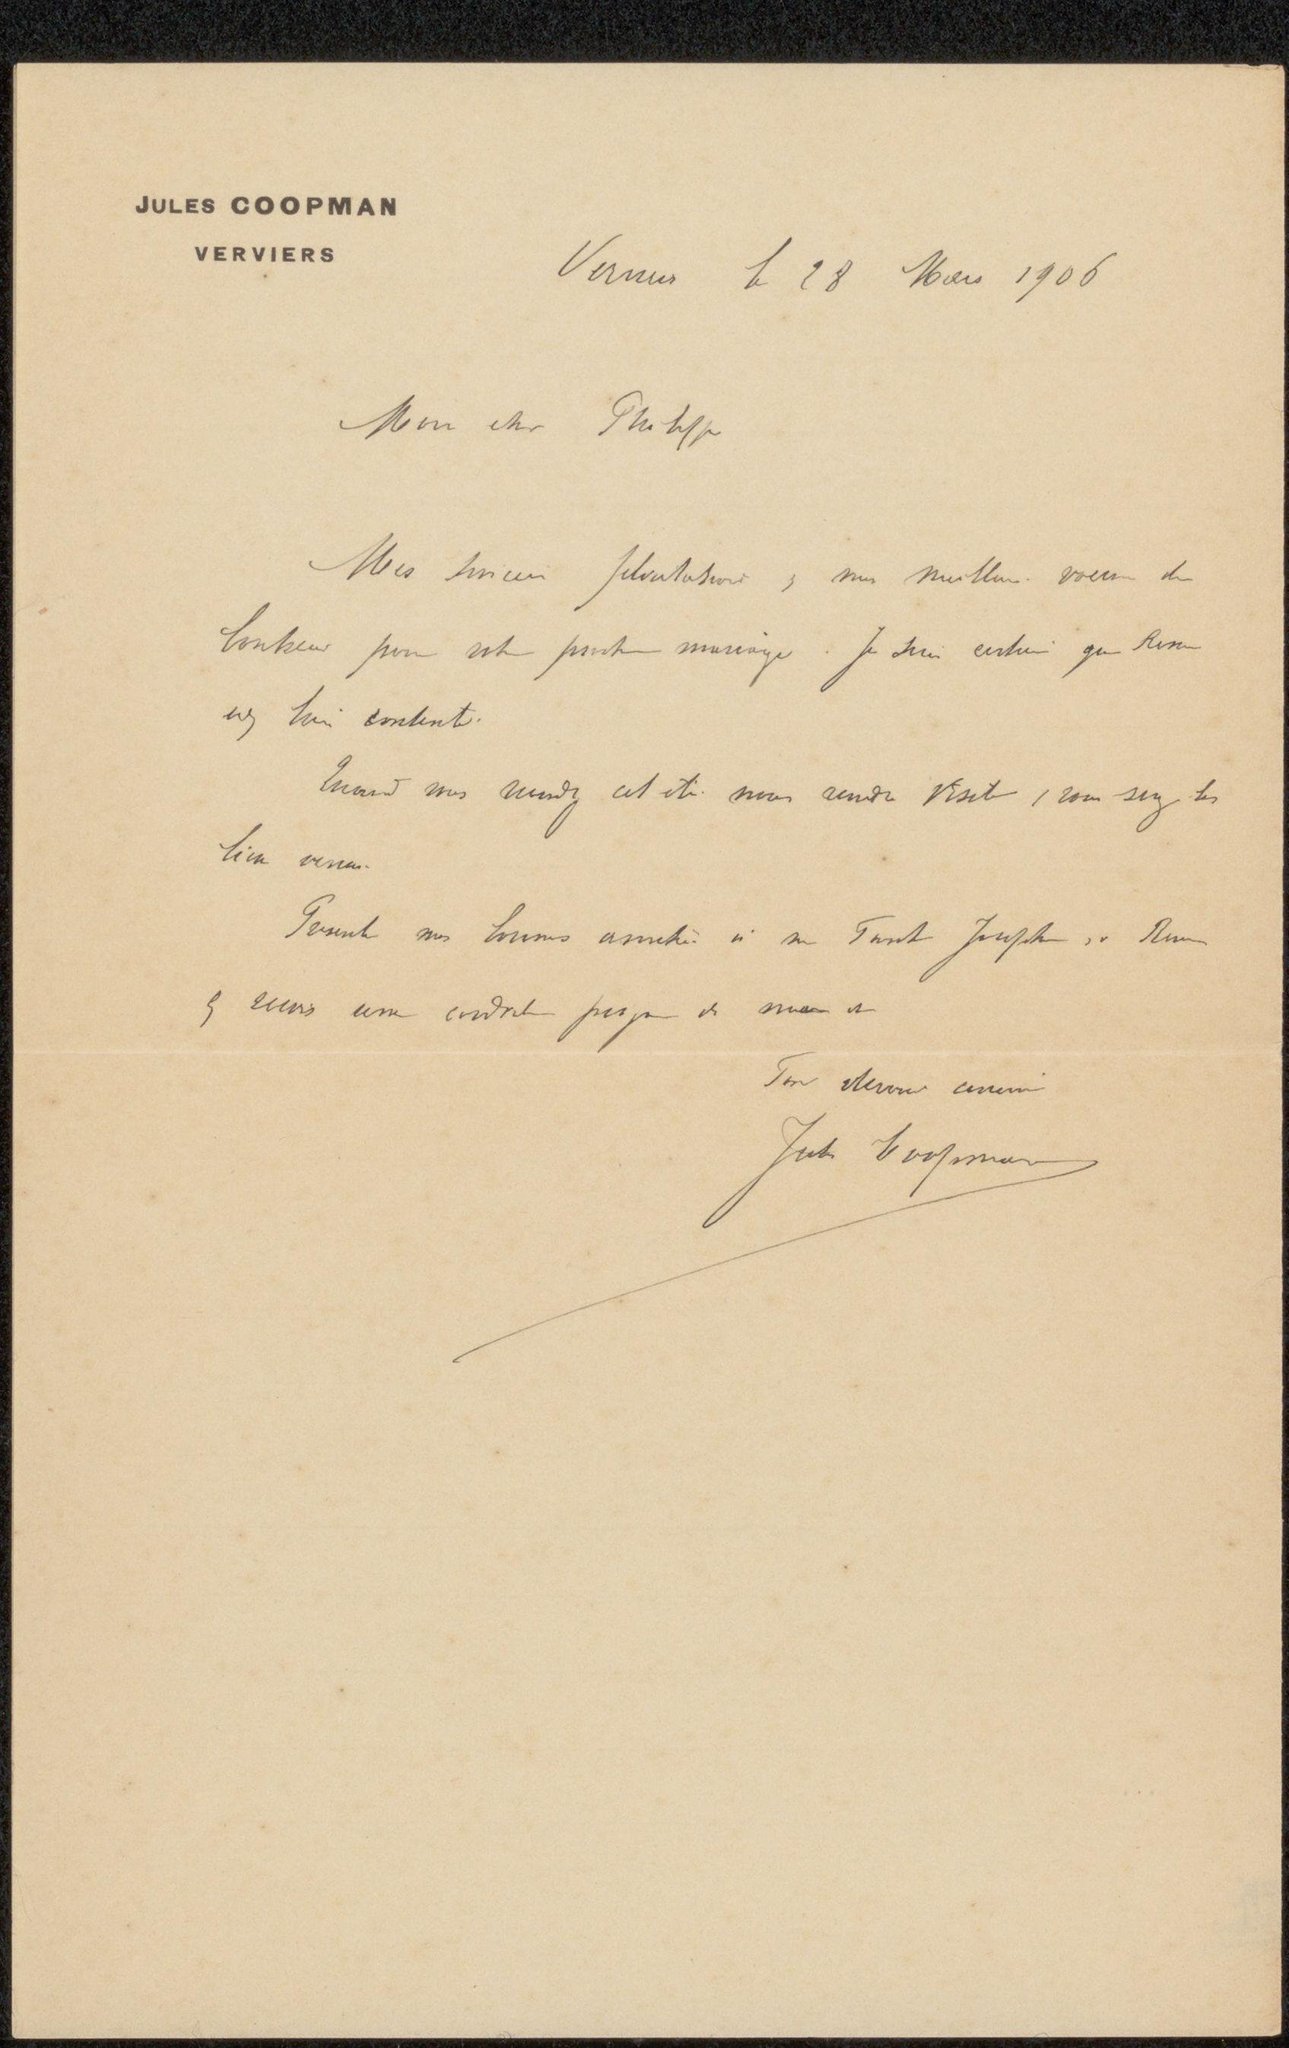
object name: letter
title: Brief aan Philip Zilcken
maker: jules coopman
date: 1906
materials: ink, paper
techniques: pen, writing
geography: verviers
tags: painter, draughtsman, philip zilcken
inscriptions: collector's mark: ‘RPK’